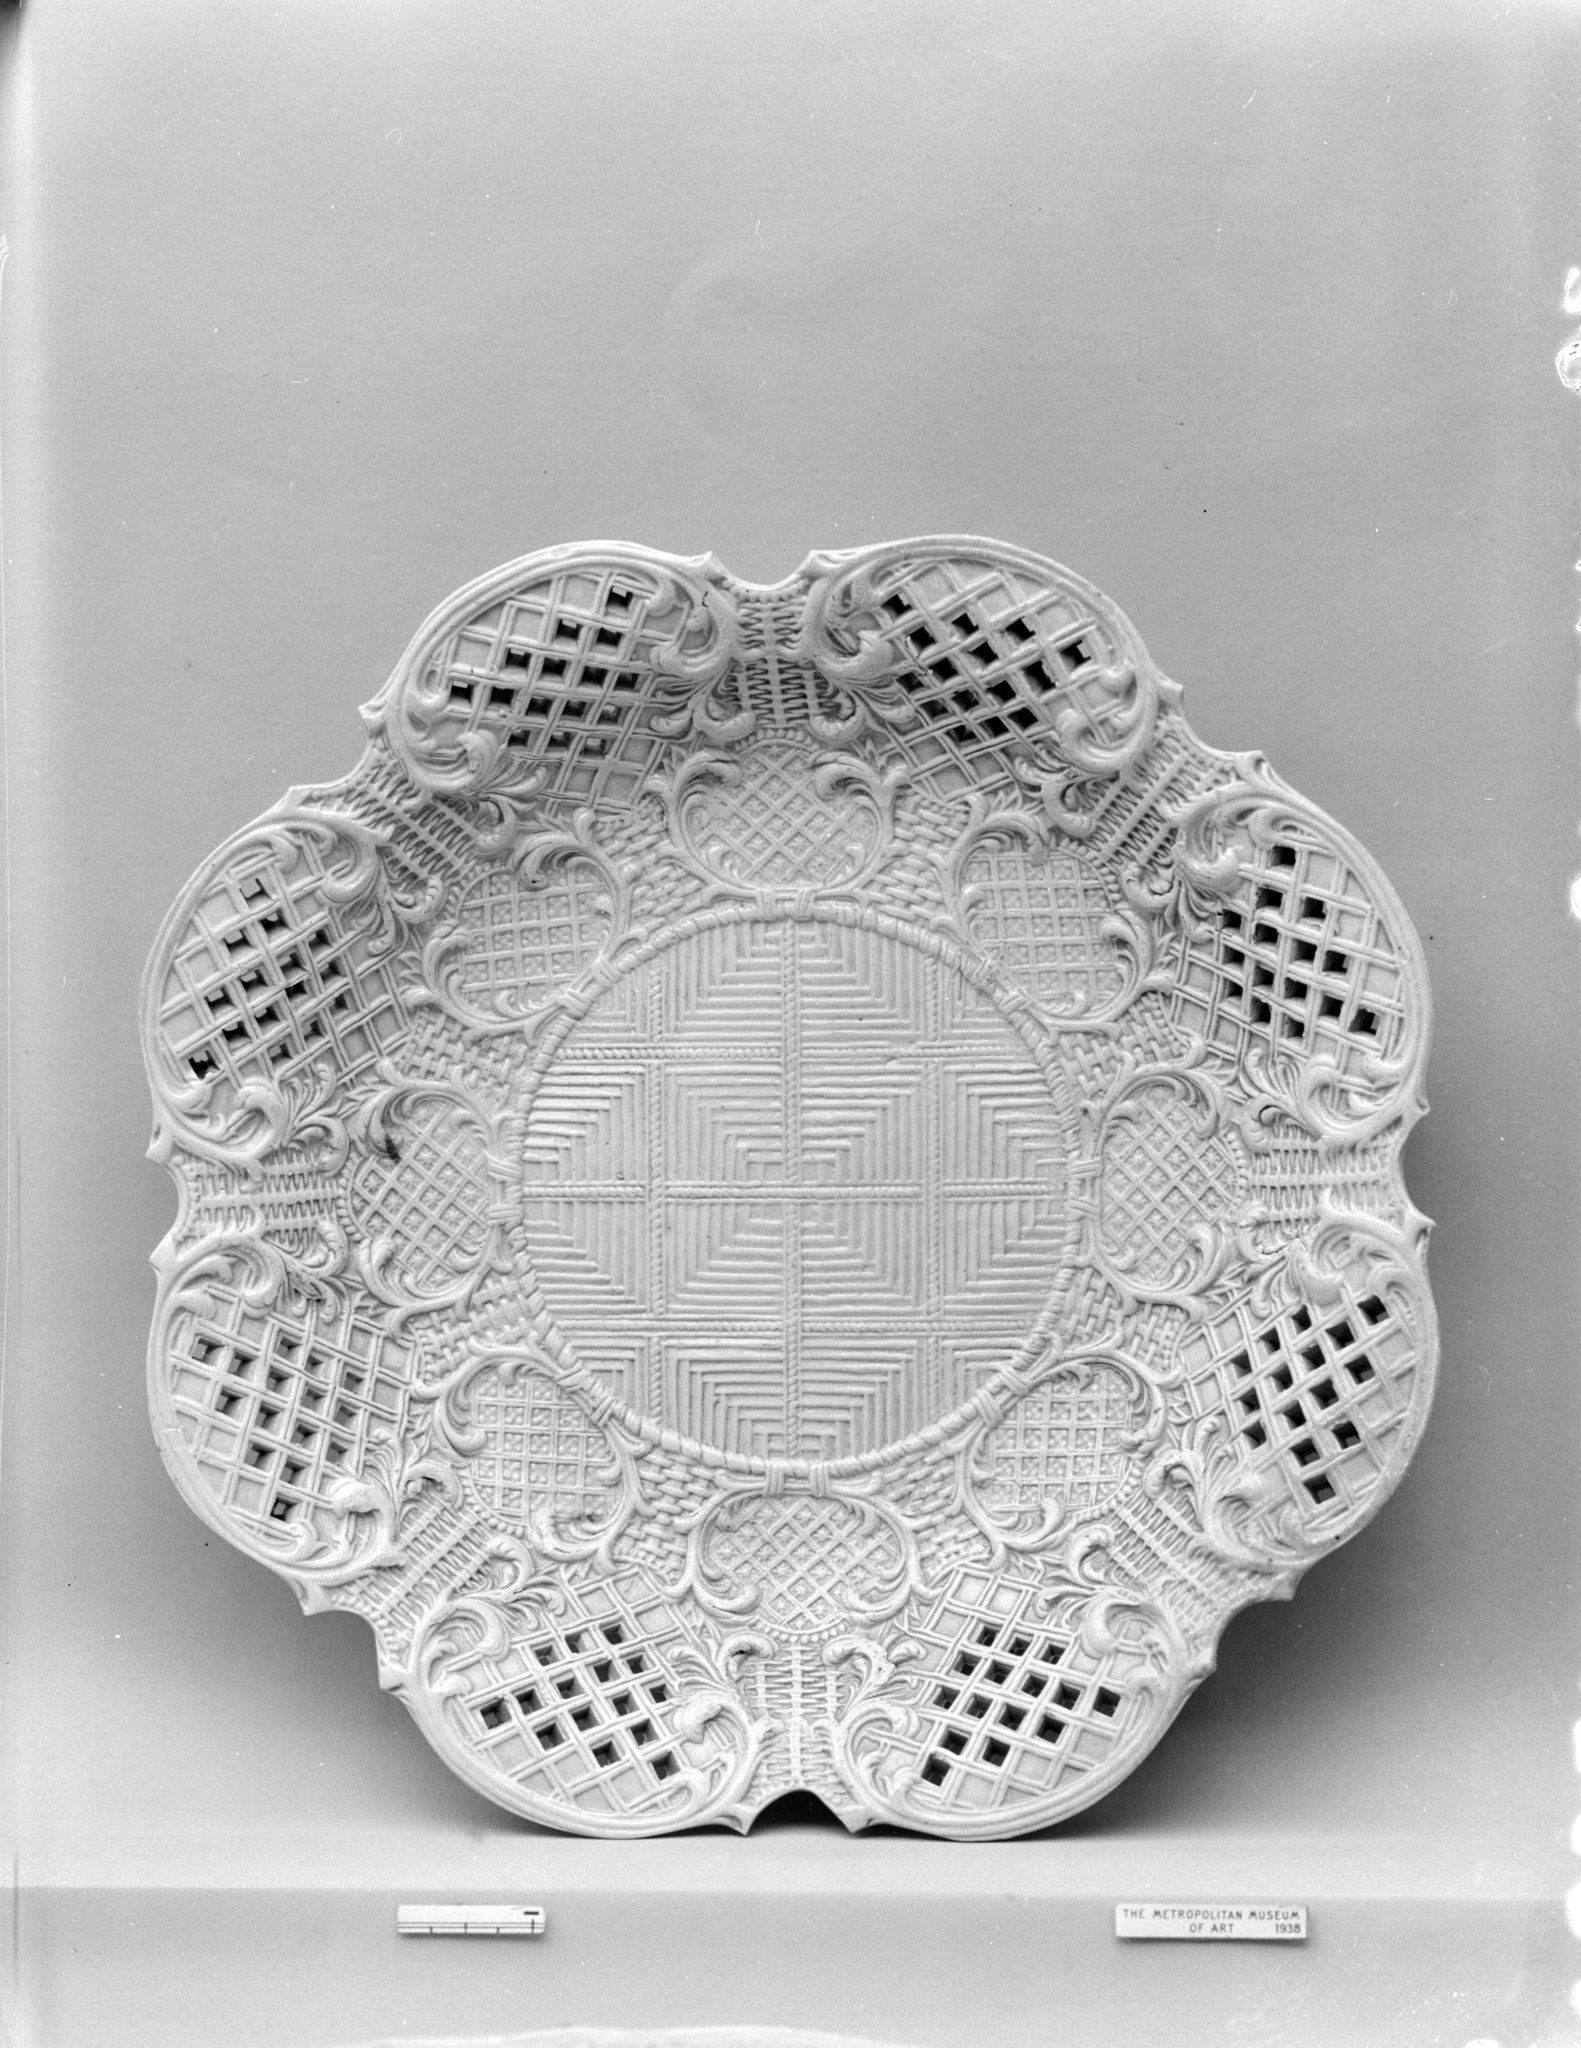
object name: dish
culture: british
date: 1750-1770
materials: stoneware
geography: england